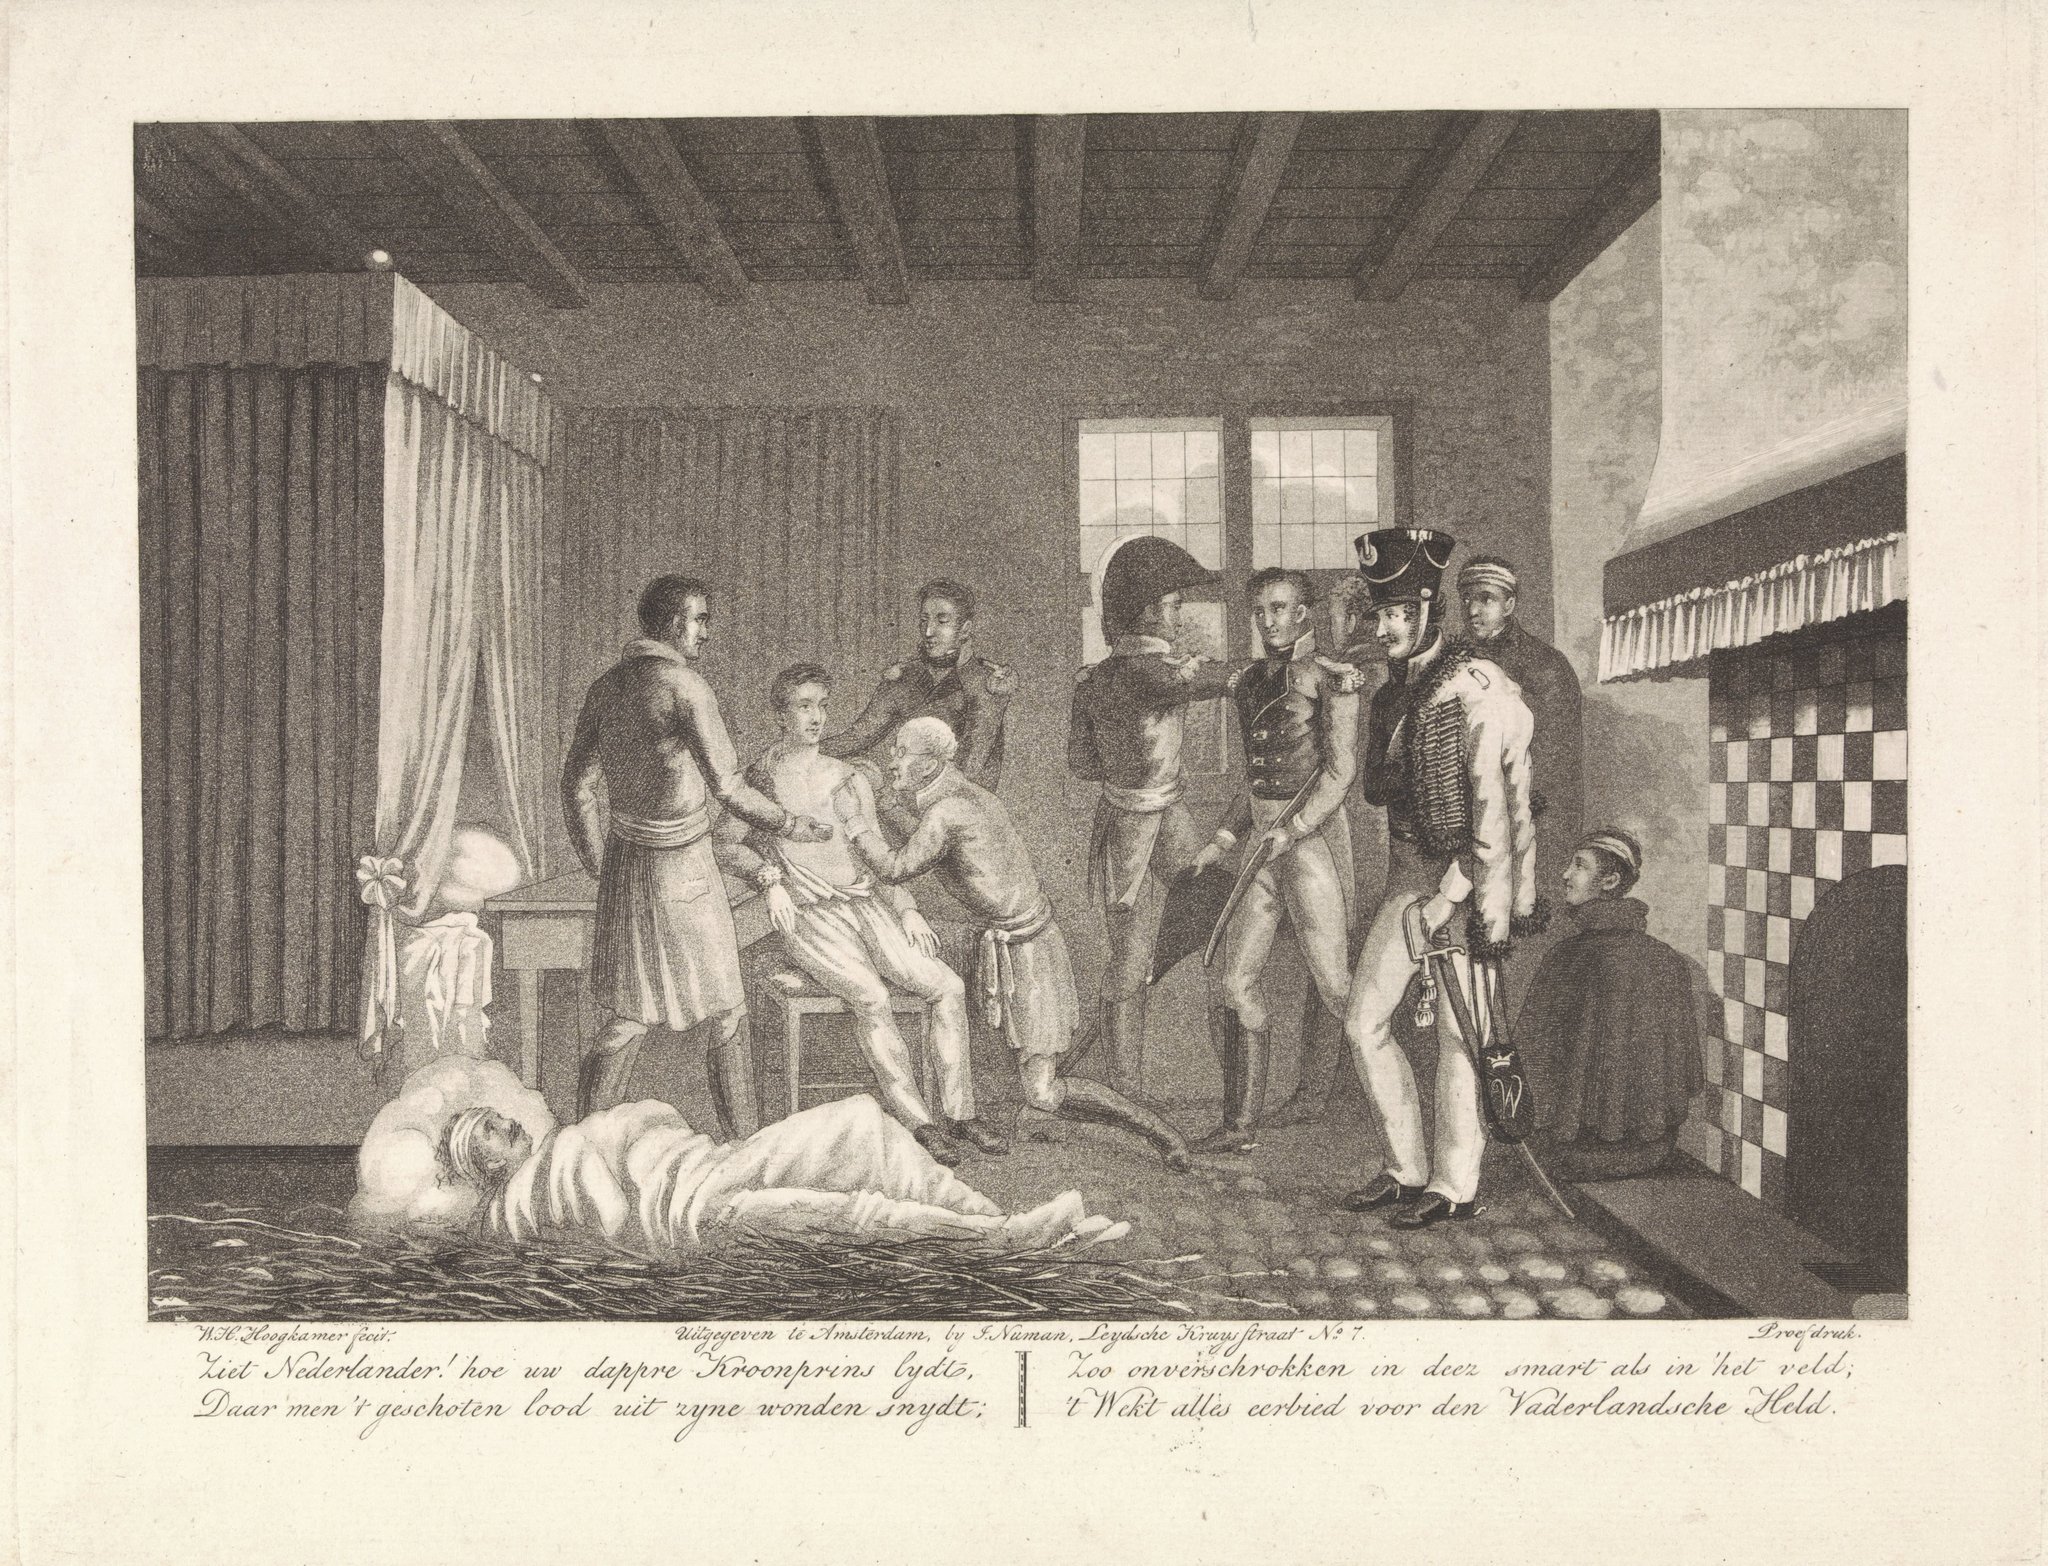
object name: print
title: Prins van Oranje na zijn verwonding onder medische behandeling in het veldhospitaal, 1815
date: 1815-1817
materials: paper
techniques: aquatint, etching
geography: netherlands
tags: the hague, william ii of the netherlands, physician, doctor, patient, sick person, medical examination, medical treatment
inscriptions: collector's mark: Lugt 2228, collector's mark: Lugt 2760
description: De prins van Oranje, de latere Willem II koning der Nederlanden, wordt behandeld door een arts in een veldhospitaal nadat hij gewond is geraakt tijdens de slag bij Waterloo, op 18 juni 1815.